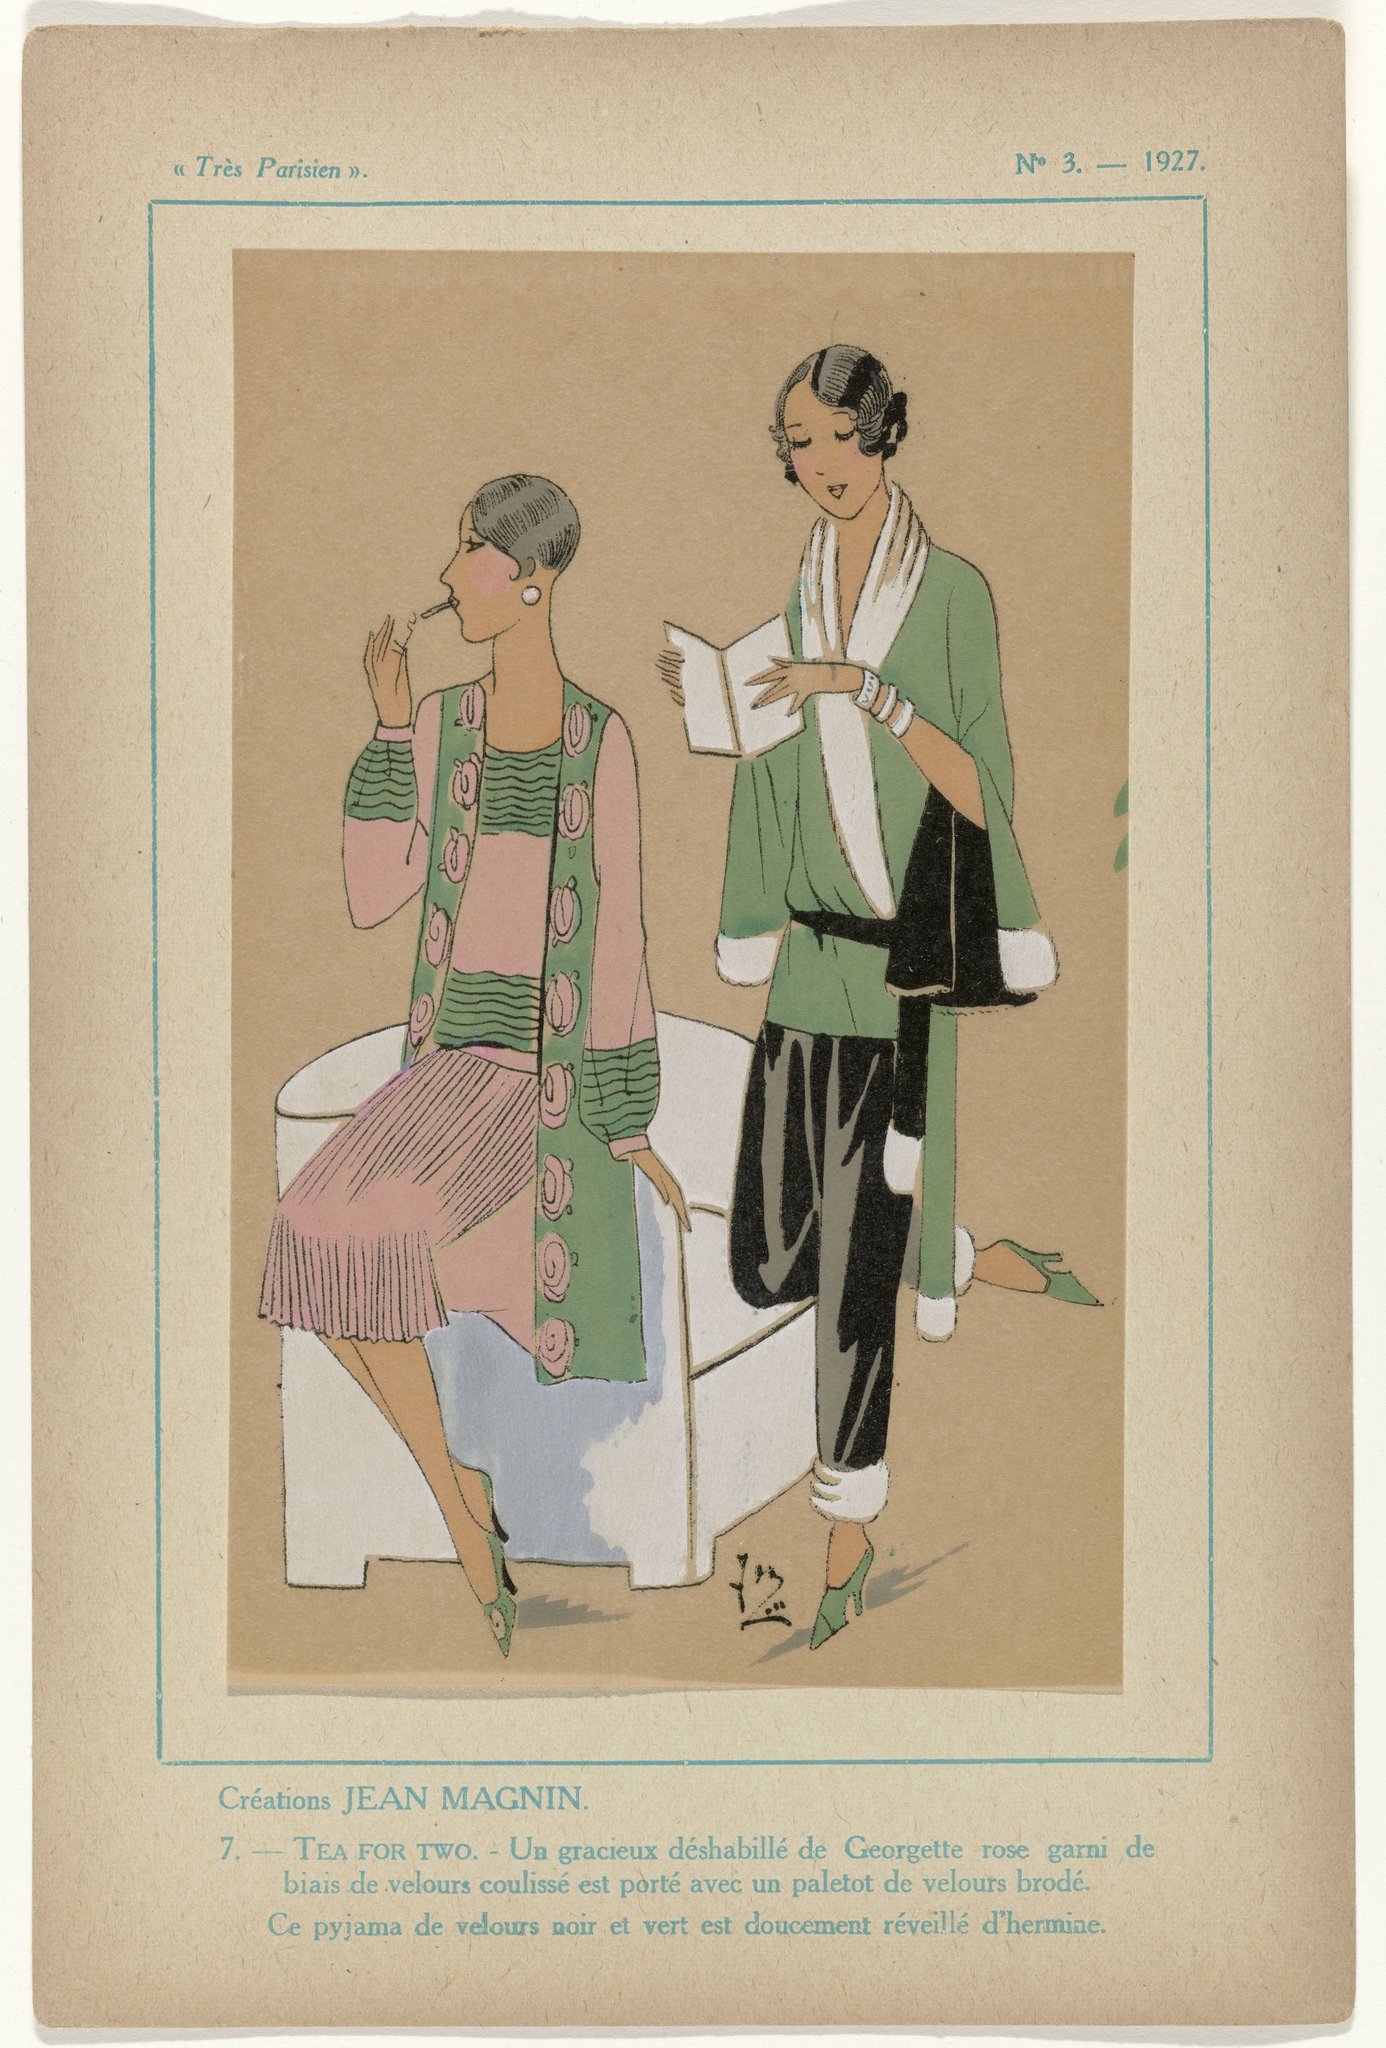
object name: fashion print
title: Très Parisien, 1927, No. 3, Pl. 7: Créations JEAN MAGNIN - TEA FOR TWO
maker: g-p. joumard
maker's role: publisher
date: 1927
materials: paper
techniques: hand coloring, letterpress printing, lithography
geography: paris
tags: cigarette, nightwear (pyjama) (+ women's clothes), dress, gown (robe d'intérieur) (+ women's clothes), ensemble of pieces of clothing (+ women's clothes), fashion plates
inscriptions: caption: ‘TEA FOR TWO. - Un gracieux deshabillé de Georgette rose garni de biais de velours coulissé est porté avec un paletot de velours brodé. Ce pyama de velours noir et vert est doucement réveillé d'hermine.’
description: Een 'deshabillé' (ensemble voor in huis) van rose crêpe Georgette. Een pyama van fluweel, afgezet met bont. Prent uit het modetijdschrift Très Parisien...La Mode, Le Chic, L'Élégance (1920-1936)